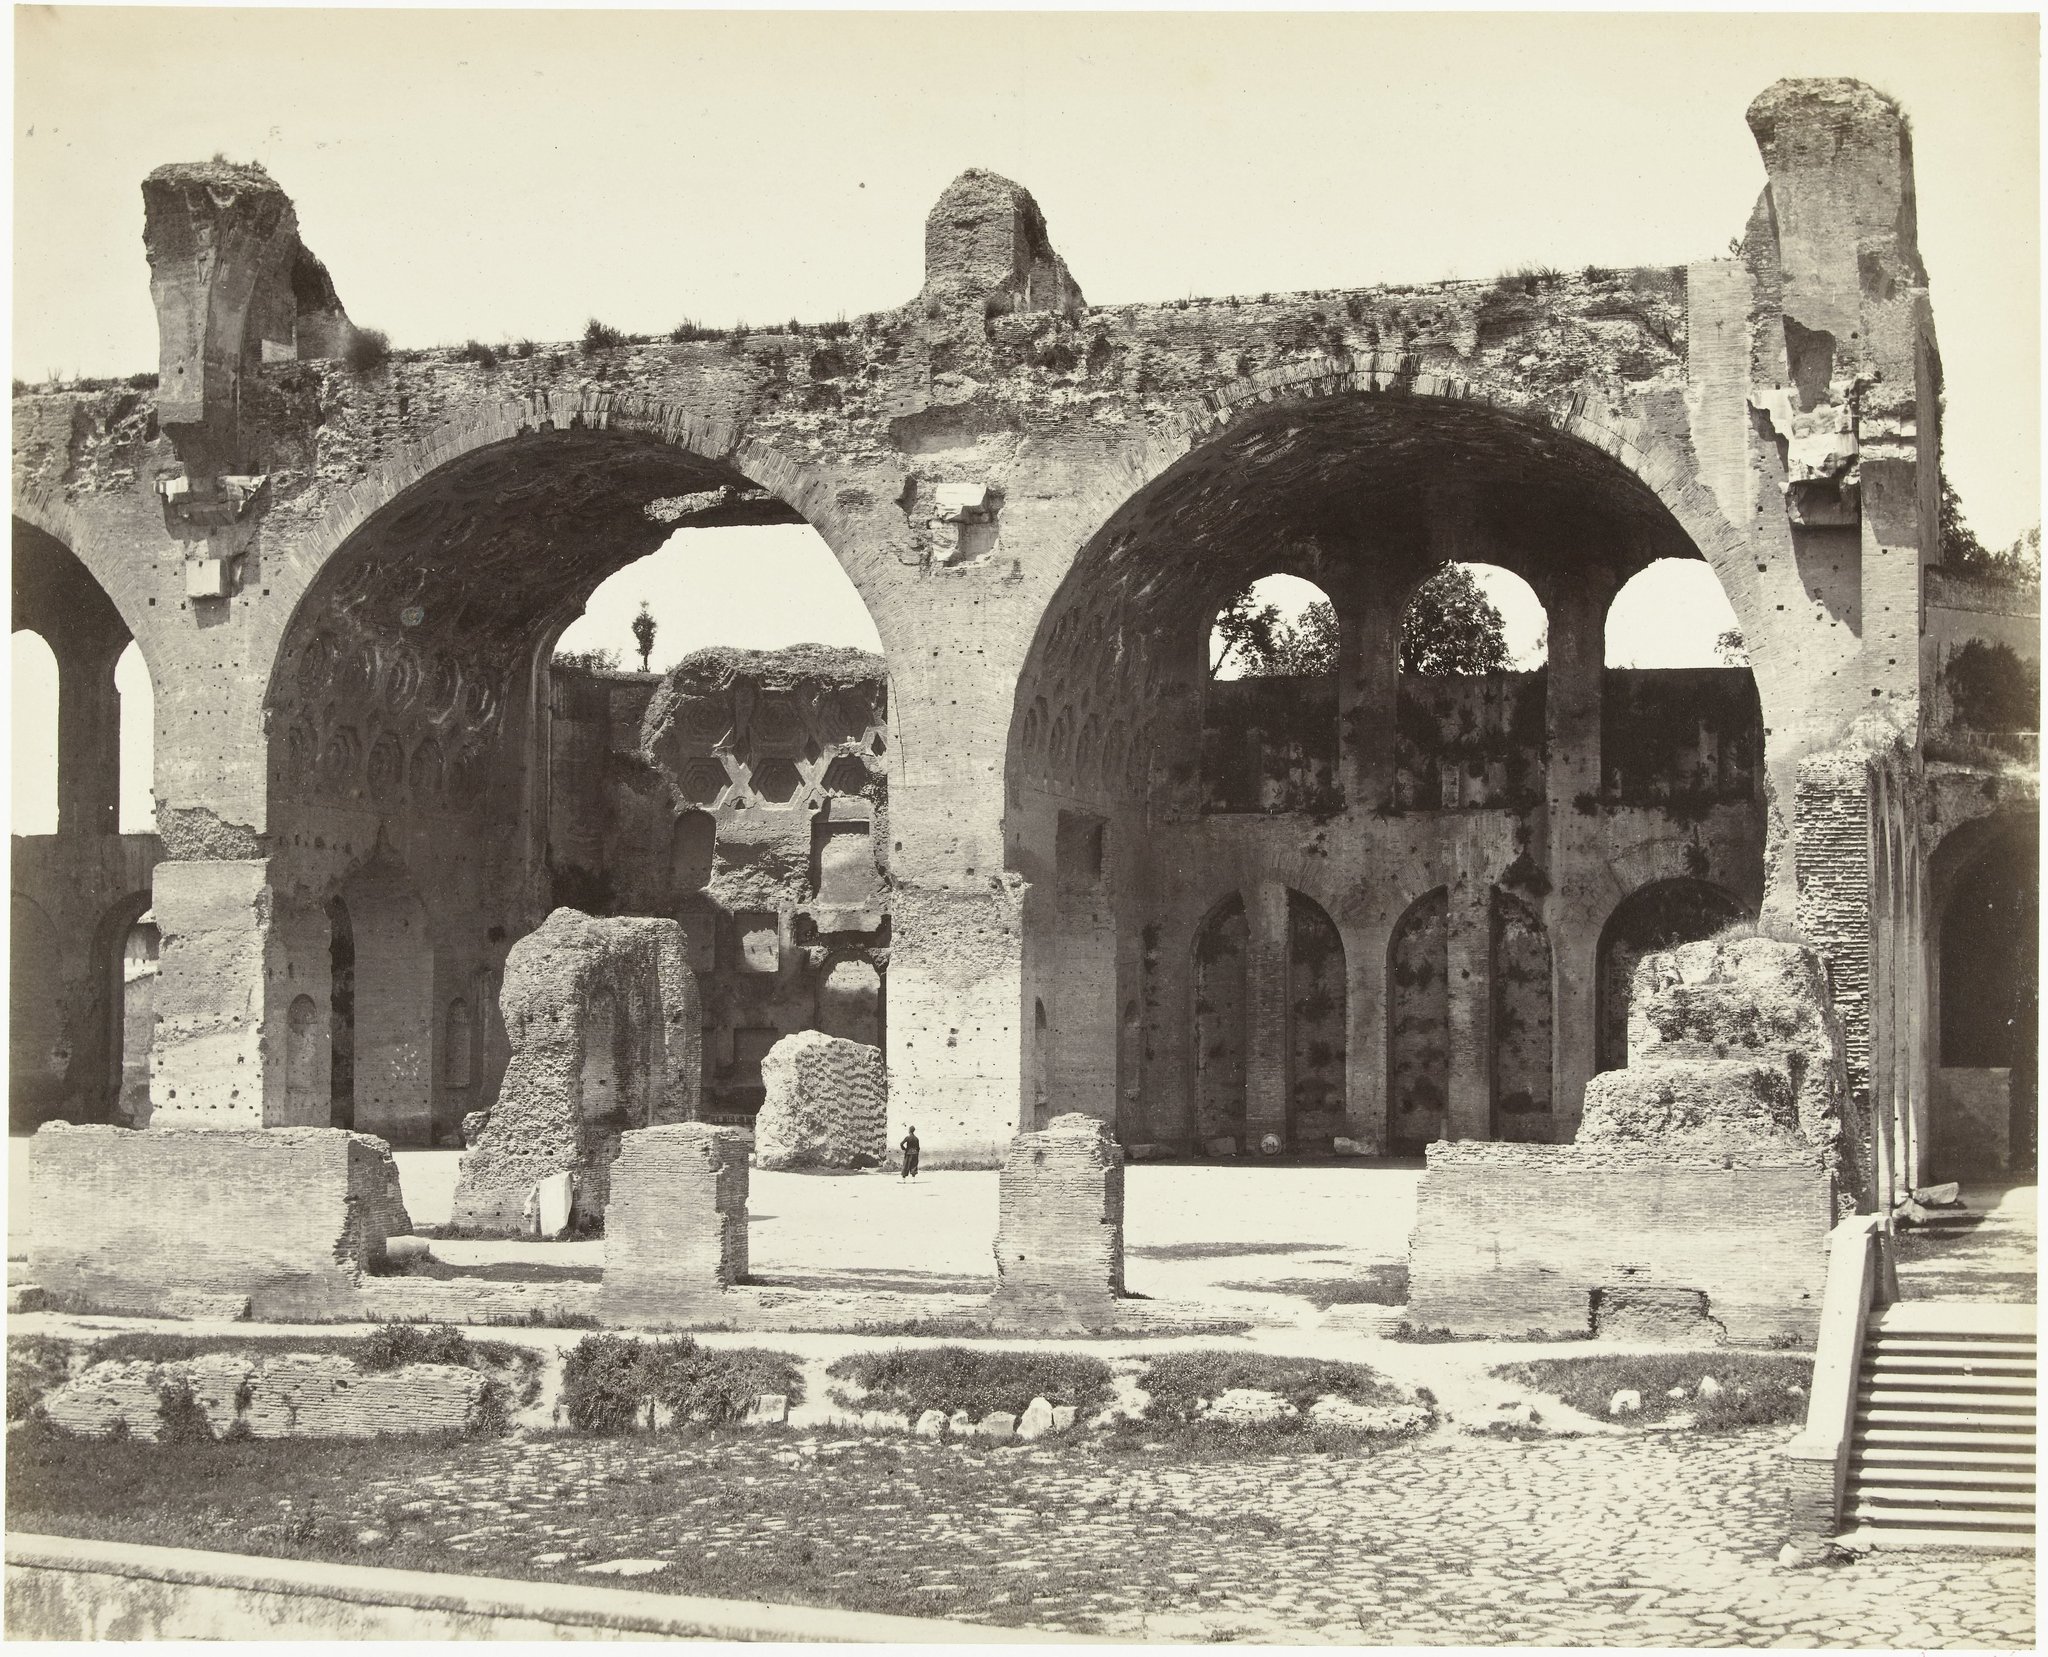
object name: photograph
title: De basiliek van Constantijn in Rome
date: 1858-1863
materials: paper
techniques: albumen print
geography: rome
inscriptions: annotation: ‘Rome 69 [...] livraison Basilique [..] Constantin 213.’, signature: ‘Bisson ainé’